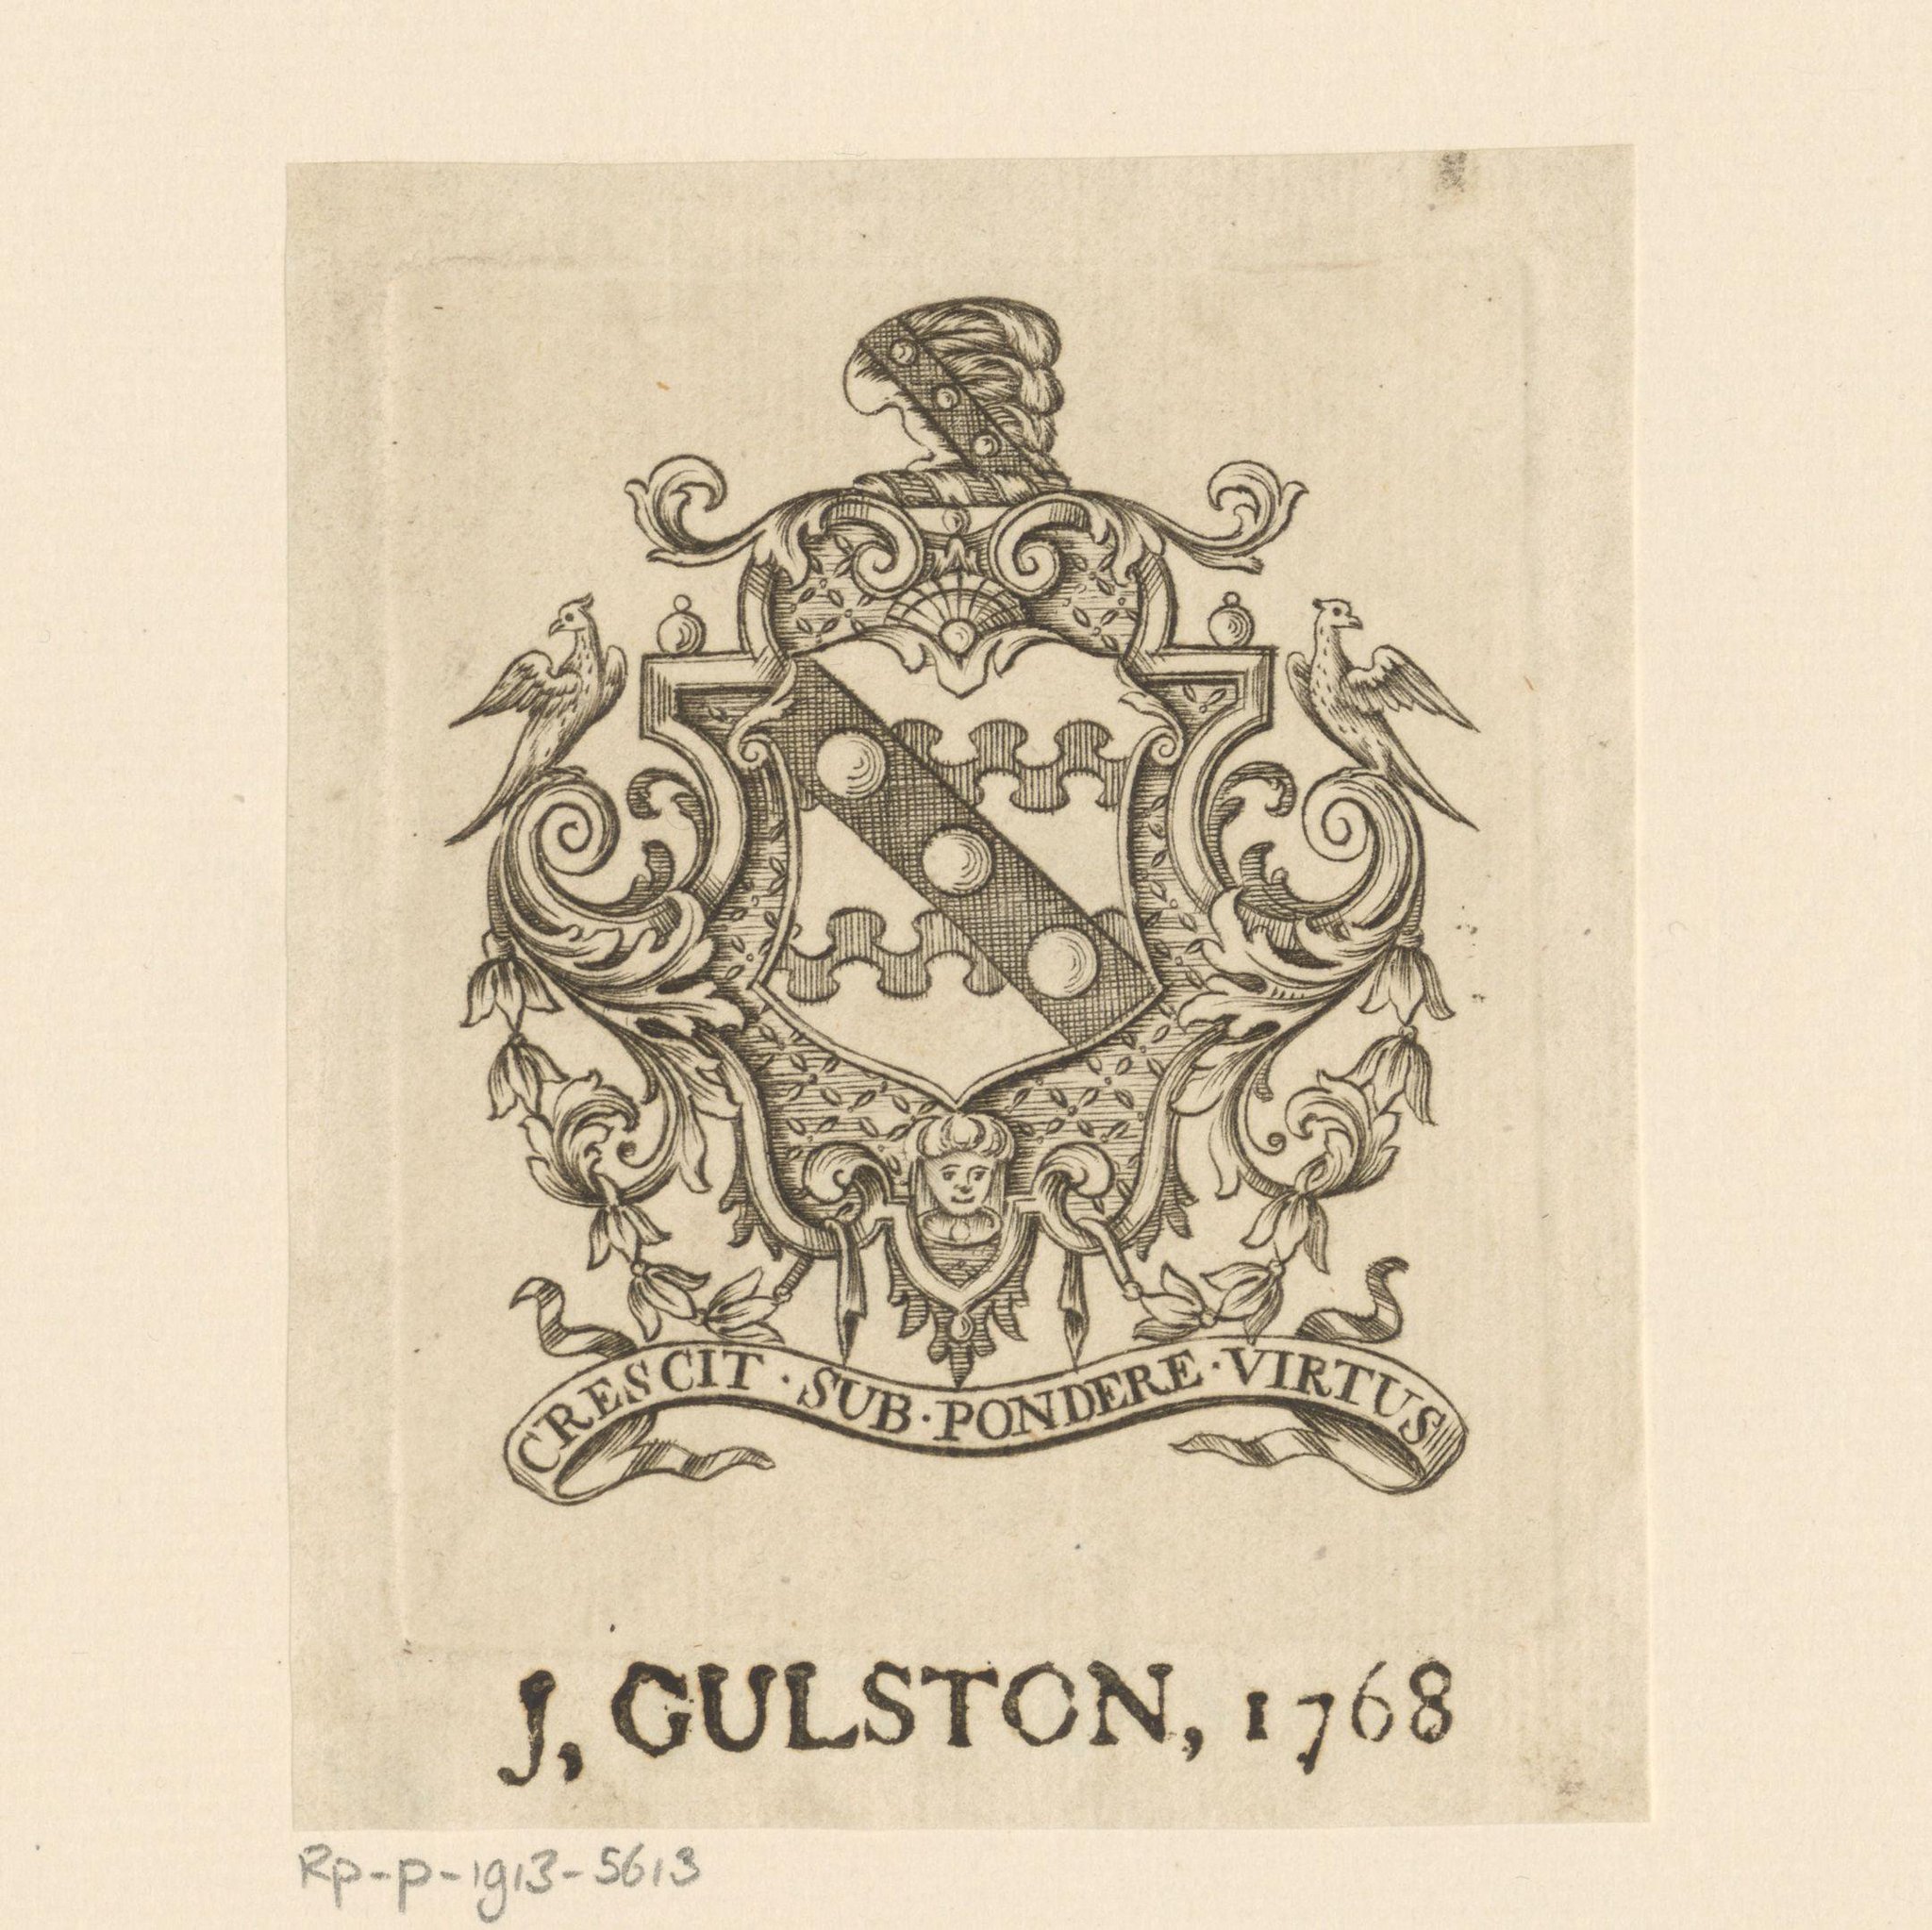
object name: bookplate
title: Crescit sub pondere virtus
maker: Anonymous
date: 1768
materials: paper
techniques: engraving, letterpress printing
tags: armorial bearing, heraldry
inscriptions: collector's mark: Lugt 2760, collector's mark: Lugt 2233